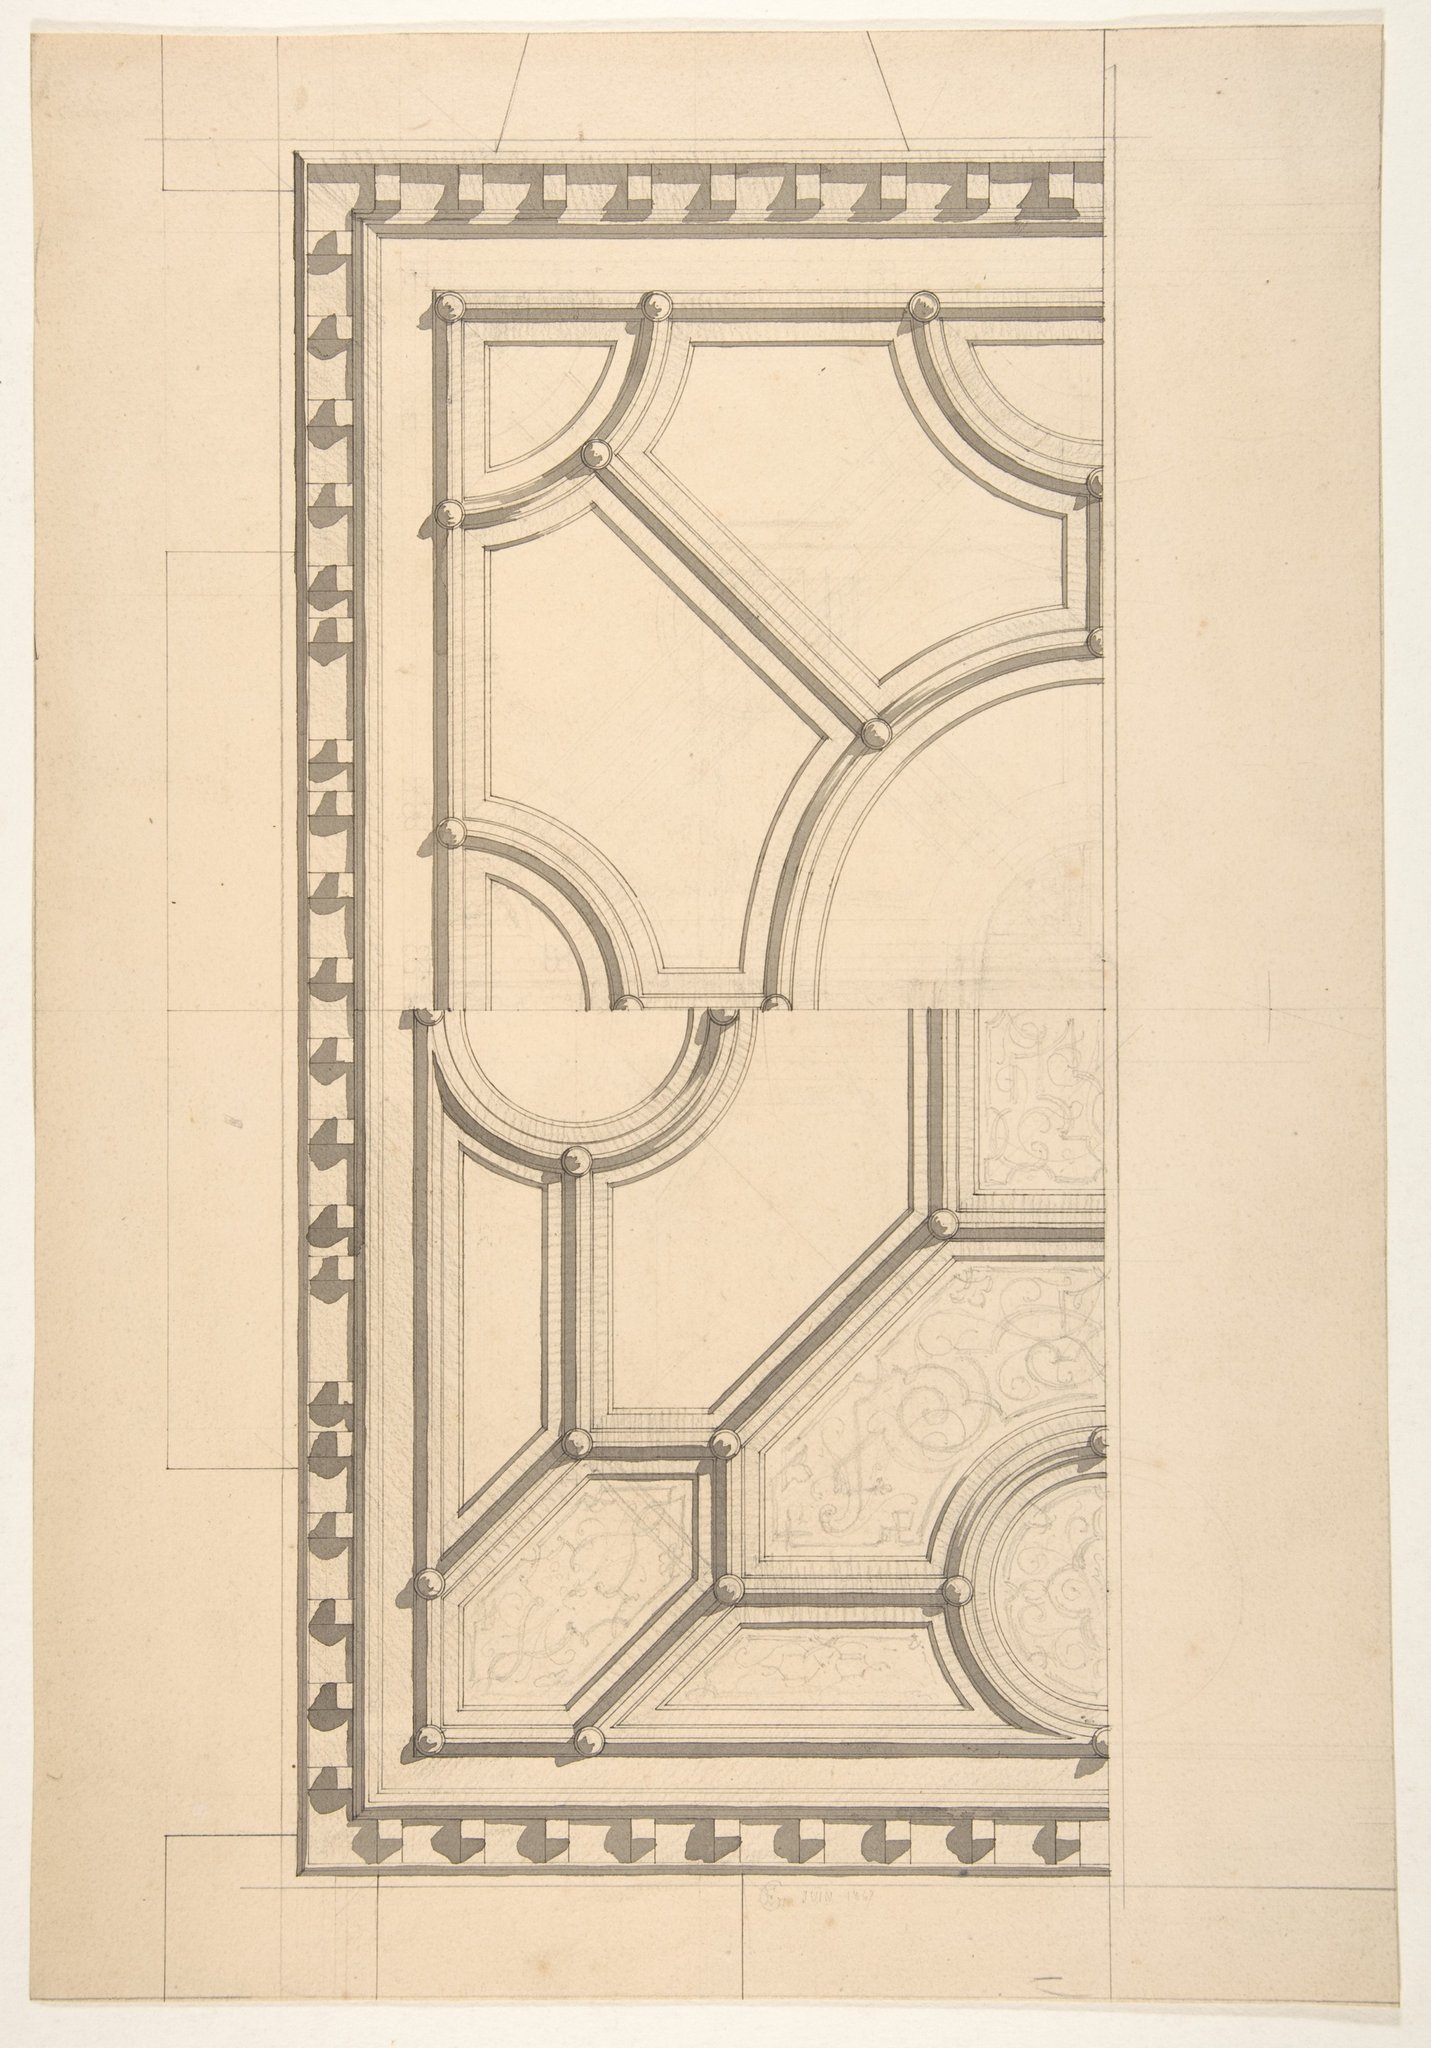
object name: drawing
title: Two designs for a ceiling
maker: jules-edmond-charles lachaise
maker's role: artist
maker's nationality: french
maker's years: 1897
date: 1851-1900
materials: graphite, ink, watercolor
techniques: pen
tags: ceilings